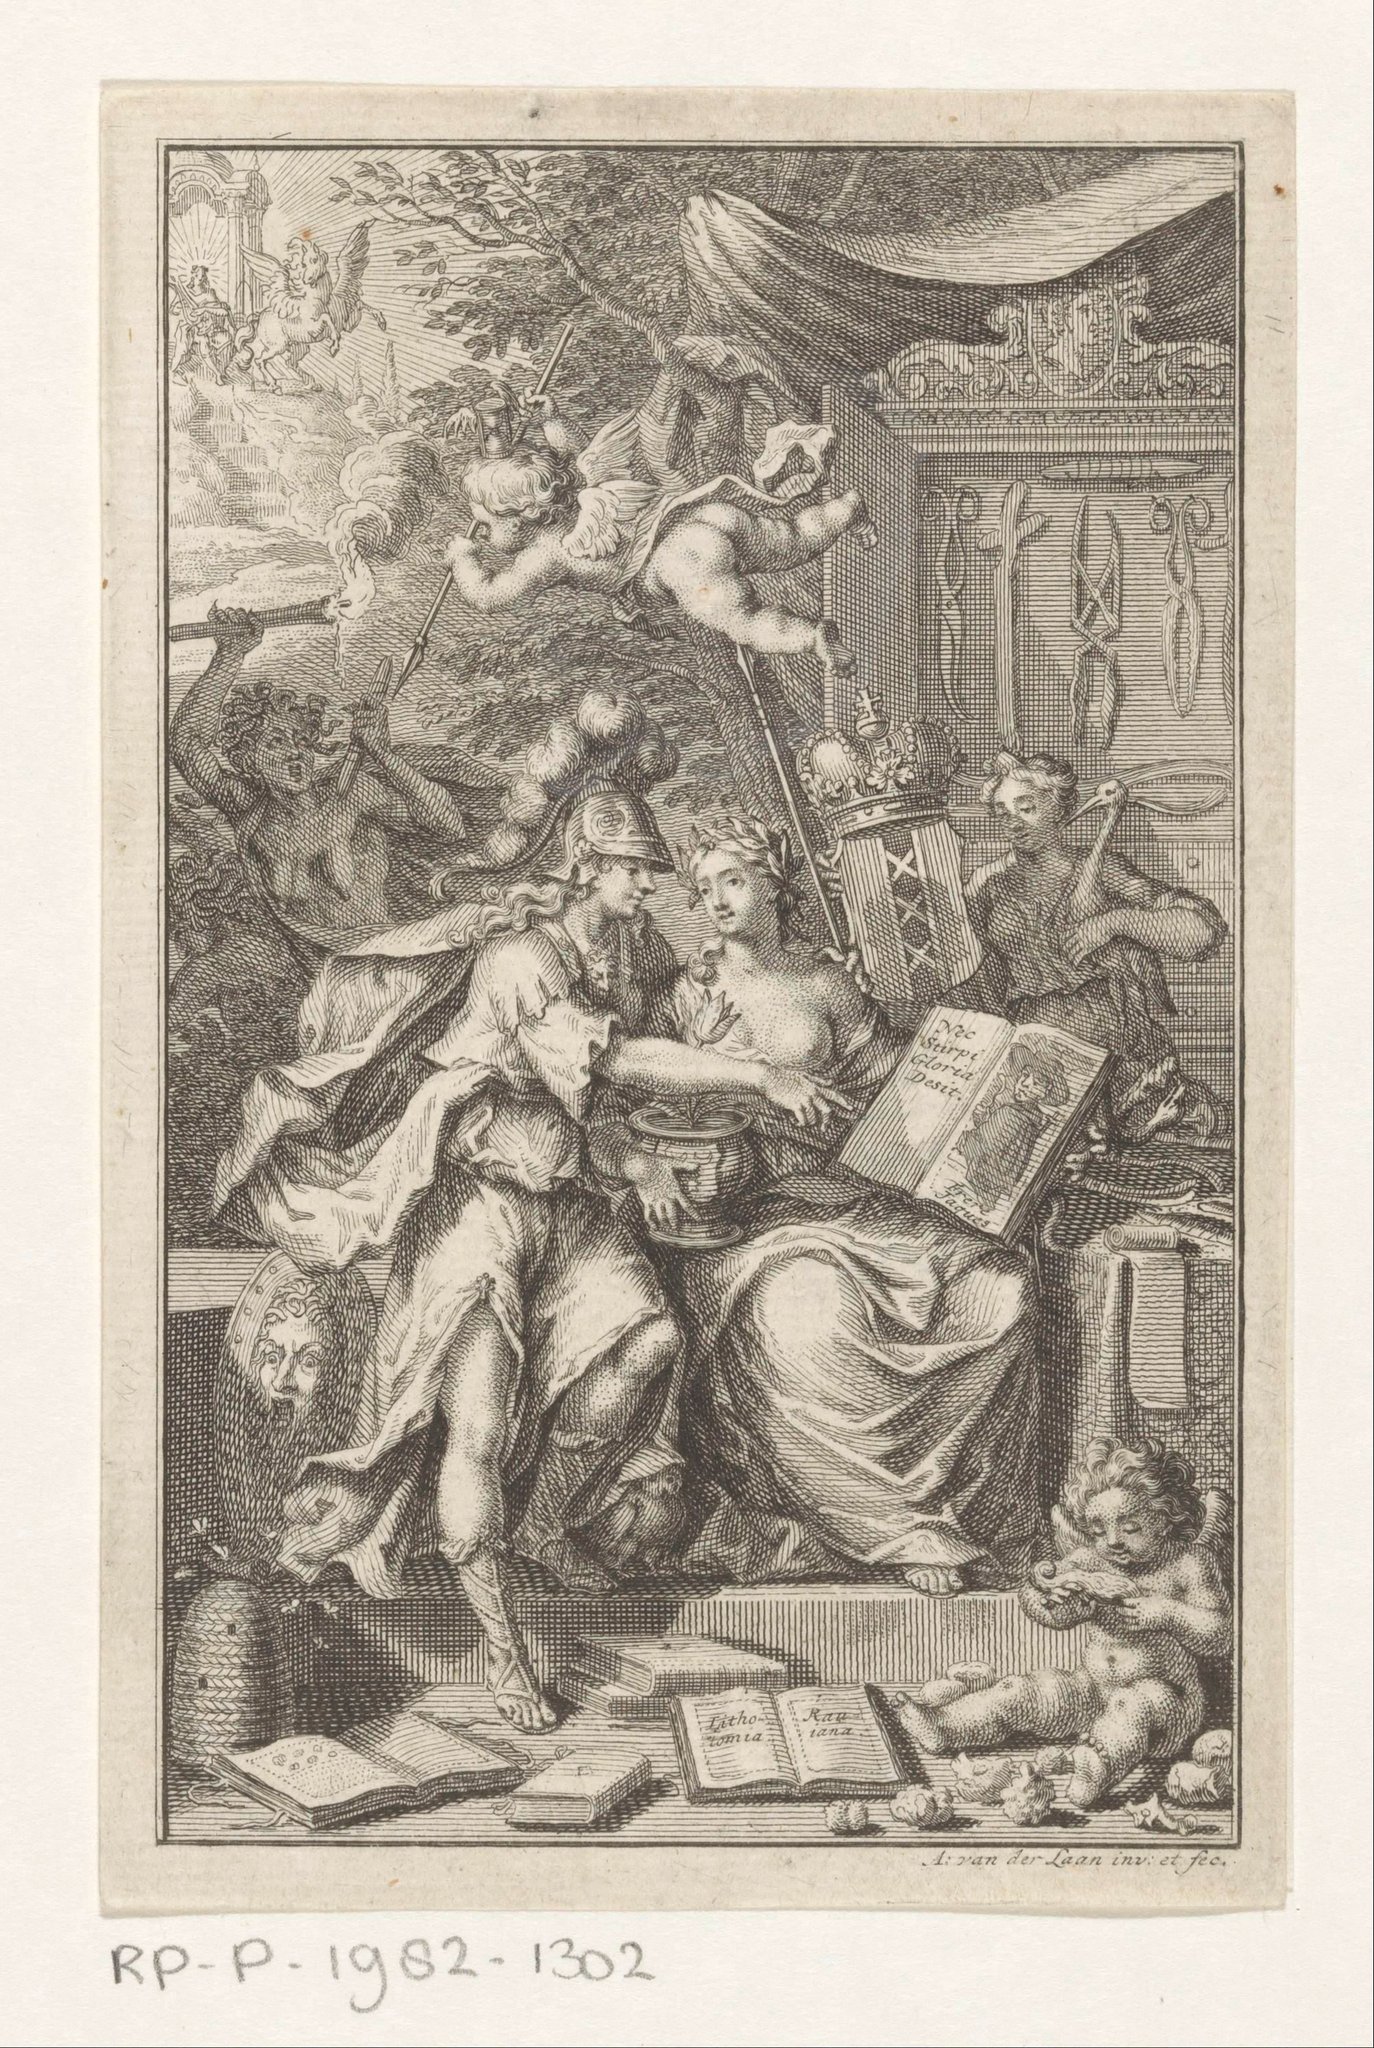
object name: titelblad, titelpagina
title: Titelpagina voor: Abraham Titsingh, Heelkundige verhandeling Over de steen en het steensnyden, 1731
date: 1731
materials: paper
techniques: etching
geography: amsterdam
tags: france, (story of) minerva (pallas, athena), 'medicina', allegorical representations ~ medicine; 'medicina' (ripa)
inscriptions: collector's mark: Lugt 2760, collector's mark: Lugt 2228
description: Heelkunde draagt een tulp in een pot en een boek met afbeelding van Frère Jacques (broeder Jacques de Beaulieu) en spreuk Nec stirpi gloria desit. Minerva zit naast haar en omhelst haar. Rechts staat een vrouw met gekroond wapen van Amsterdam. Aan de bovenzijde vliegt een putto met speer en zandloper als personificatie van Tijd en jaagt Afgunst weg. In de achtergrond Apollo en Pegasus op de berg Parnassus. Op de voorgrond liggen boeken en zit een putto met blaasstenen.